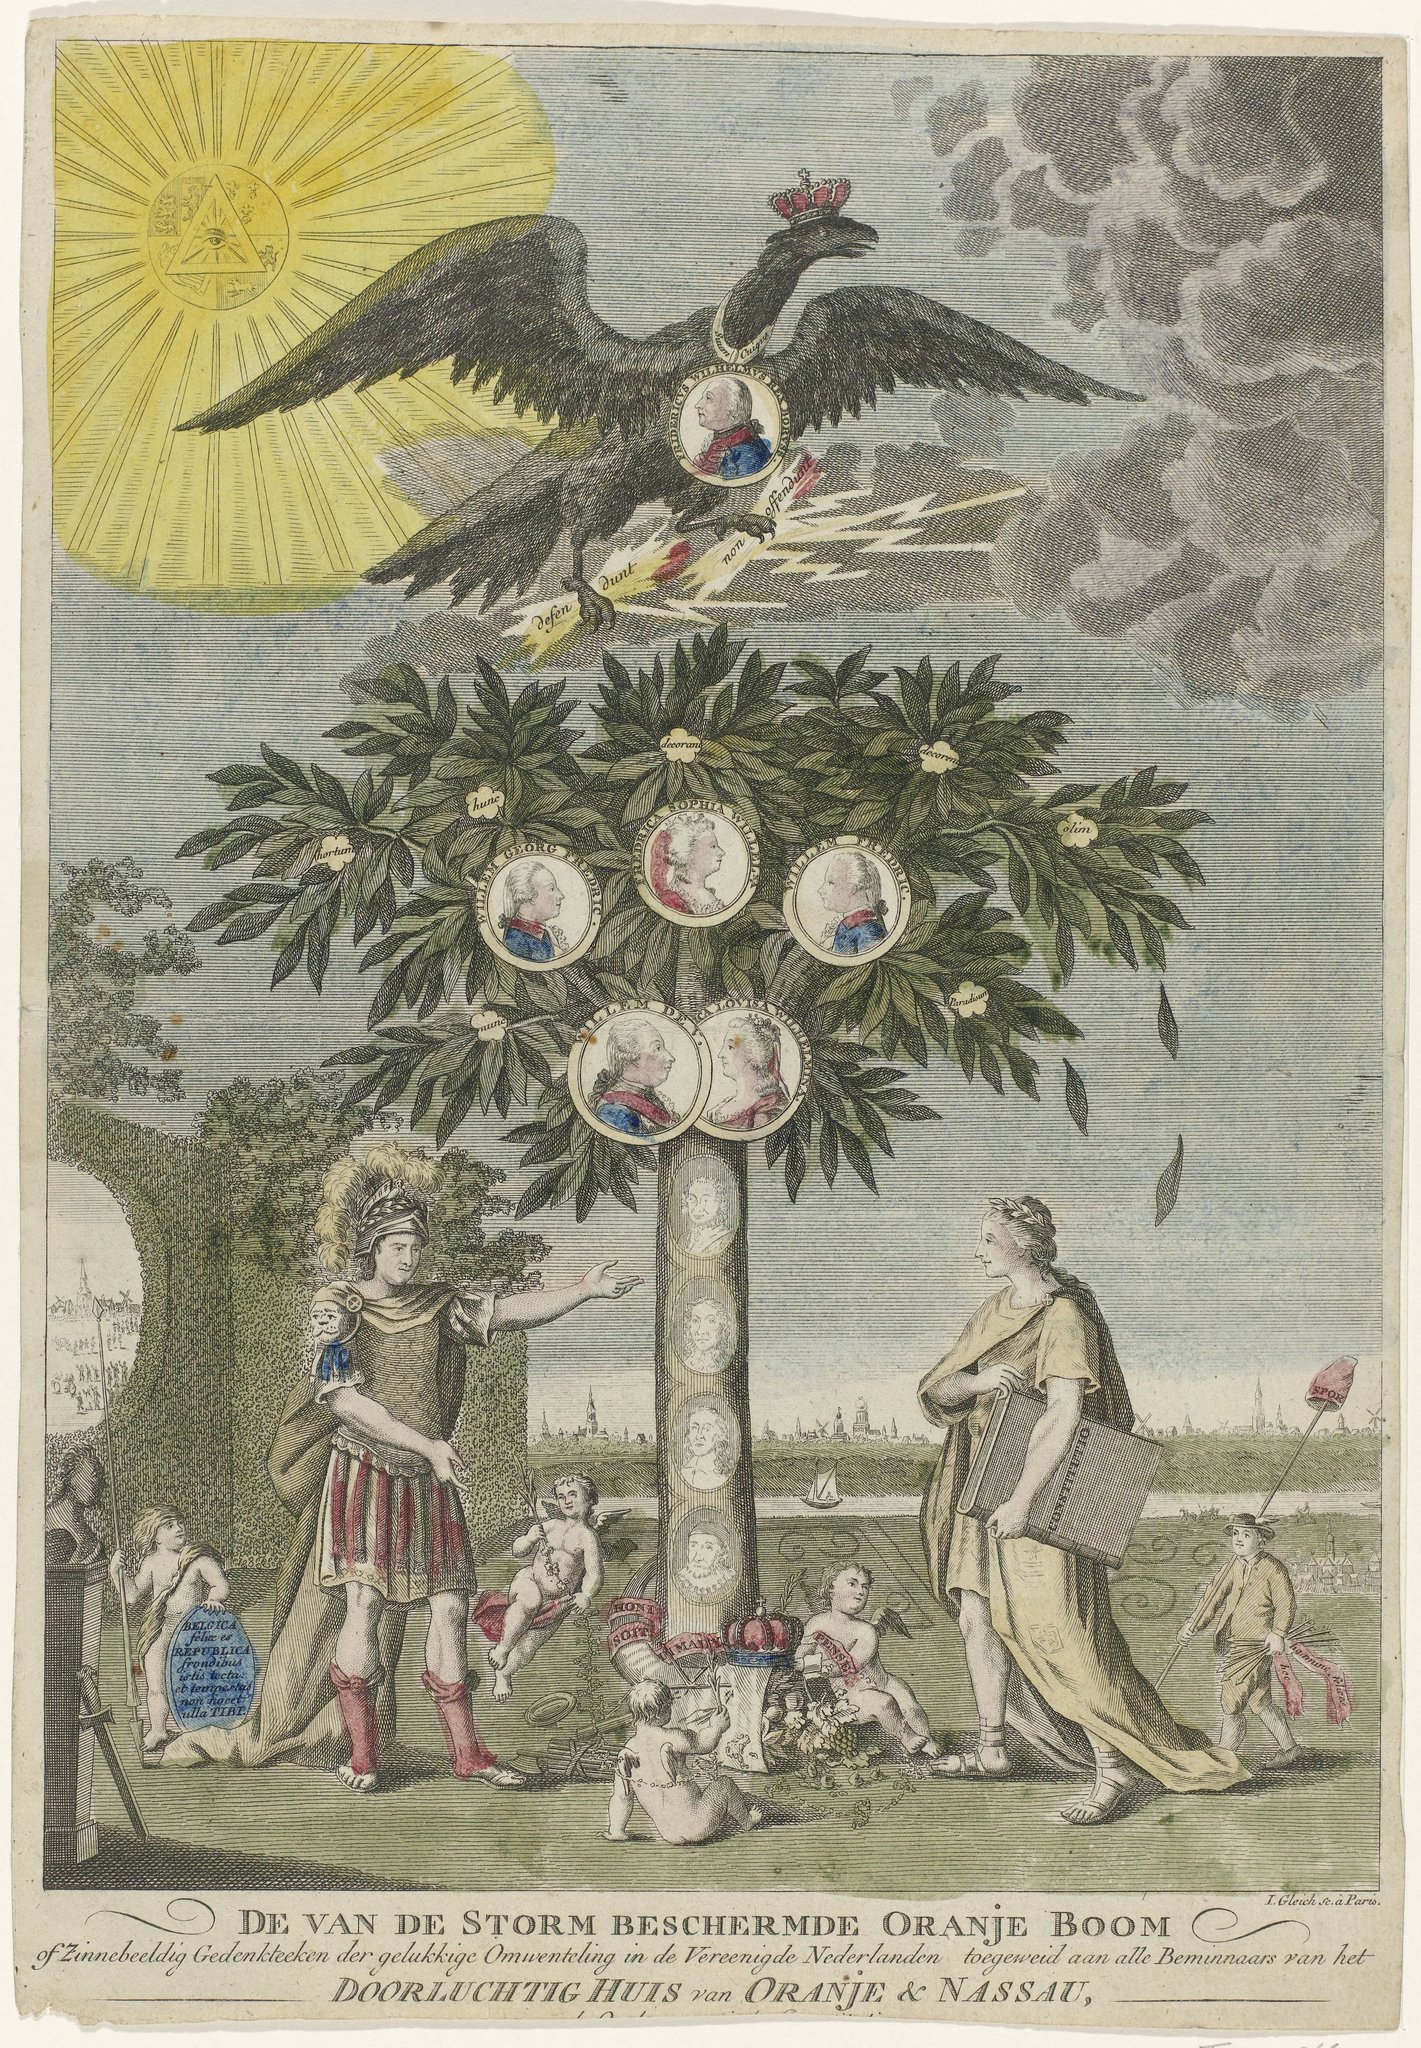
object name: print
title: Allegorie op het herstel van stadhouder Willem V (kopie), 1787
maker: joseph gleich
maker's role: print maker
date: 1787-1788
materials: paper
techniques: engraving, etching, hand coloring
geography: paris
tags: william v (prince of orange), karel willem ferdinand hertog van brunswijk-wolfenbüttel, berlin, painter, draughtsman, wilhelmina of prussia (princess of orange), the hague, predatory birds: eagle, the all-seeing eye, triangle with eye ~ symbol of god the father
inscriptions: collector's mark: Lugt 2228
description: Allegorie op het herstel van stadhouder Willem V in 1787. In de Oranjeboom hangen in medaillons de portretten van de stadhouder, zijn gemalin en kinderen en (aan de stam) die van zijn voorouders. De boom wordt beschermd door de Pruisische adelaar. Linksboven het Alziend Oog. Links van de boom staat de hertog van Brunswijk-Wolfenbüttel in de gedaante van Mars, rechts Bentinck van Rhoon als de Republiek.